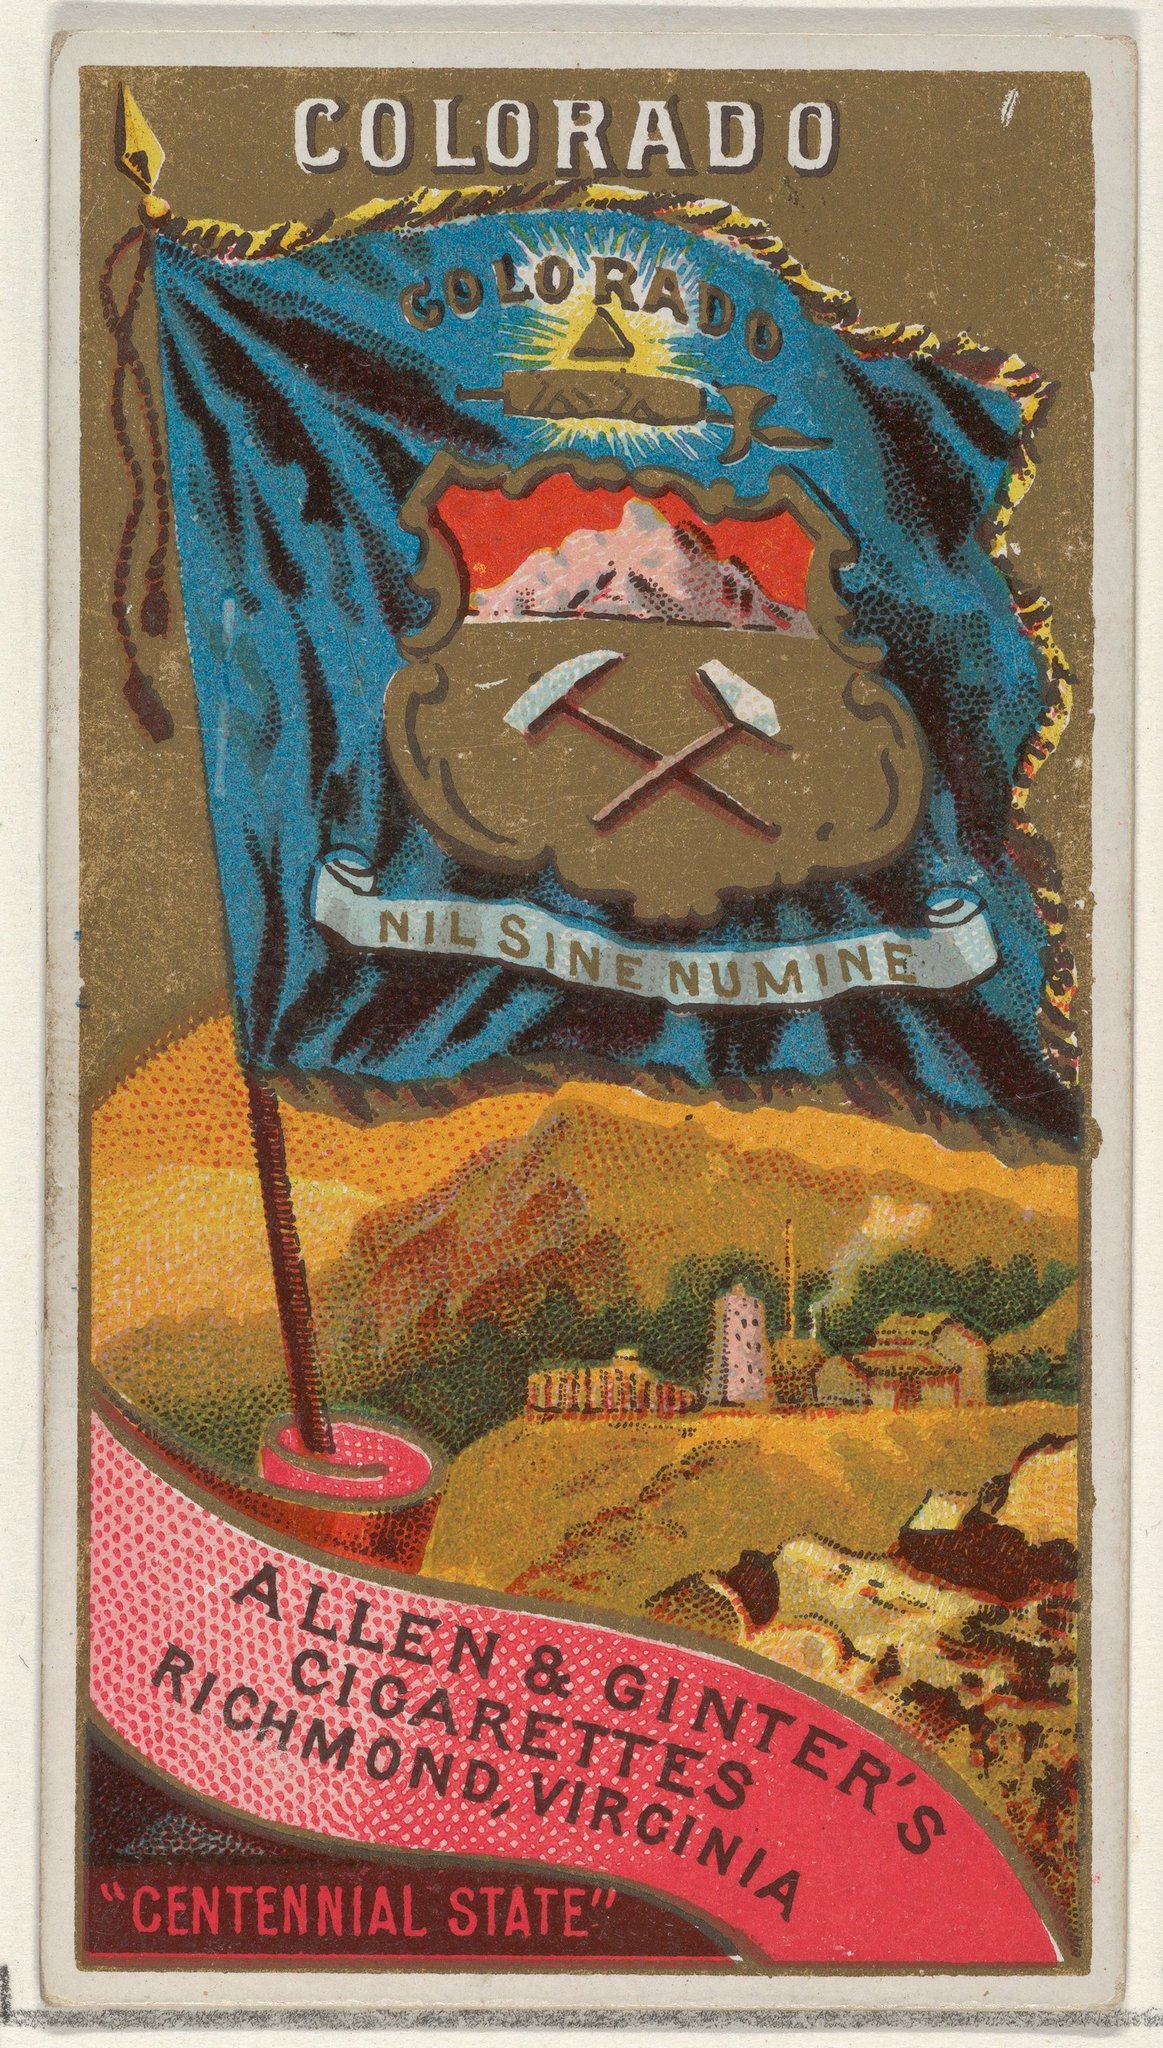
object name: print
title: Colorado, from Flags of the States and Territories (N11) for Allen & Ginter Cigarettes Brands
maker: allen & ginter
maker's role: publisher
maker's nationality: american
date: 1888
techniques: color lithograph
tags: coat of arms,flags